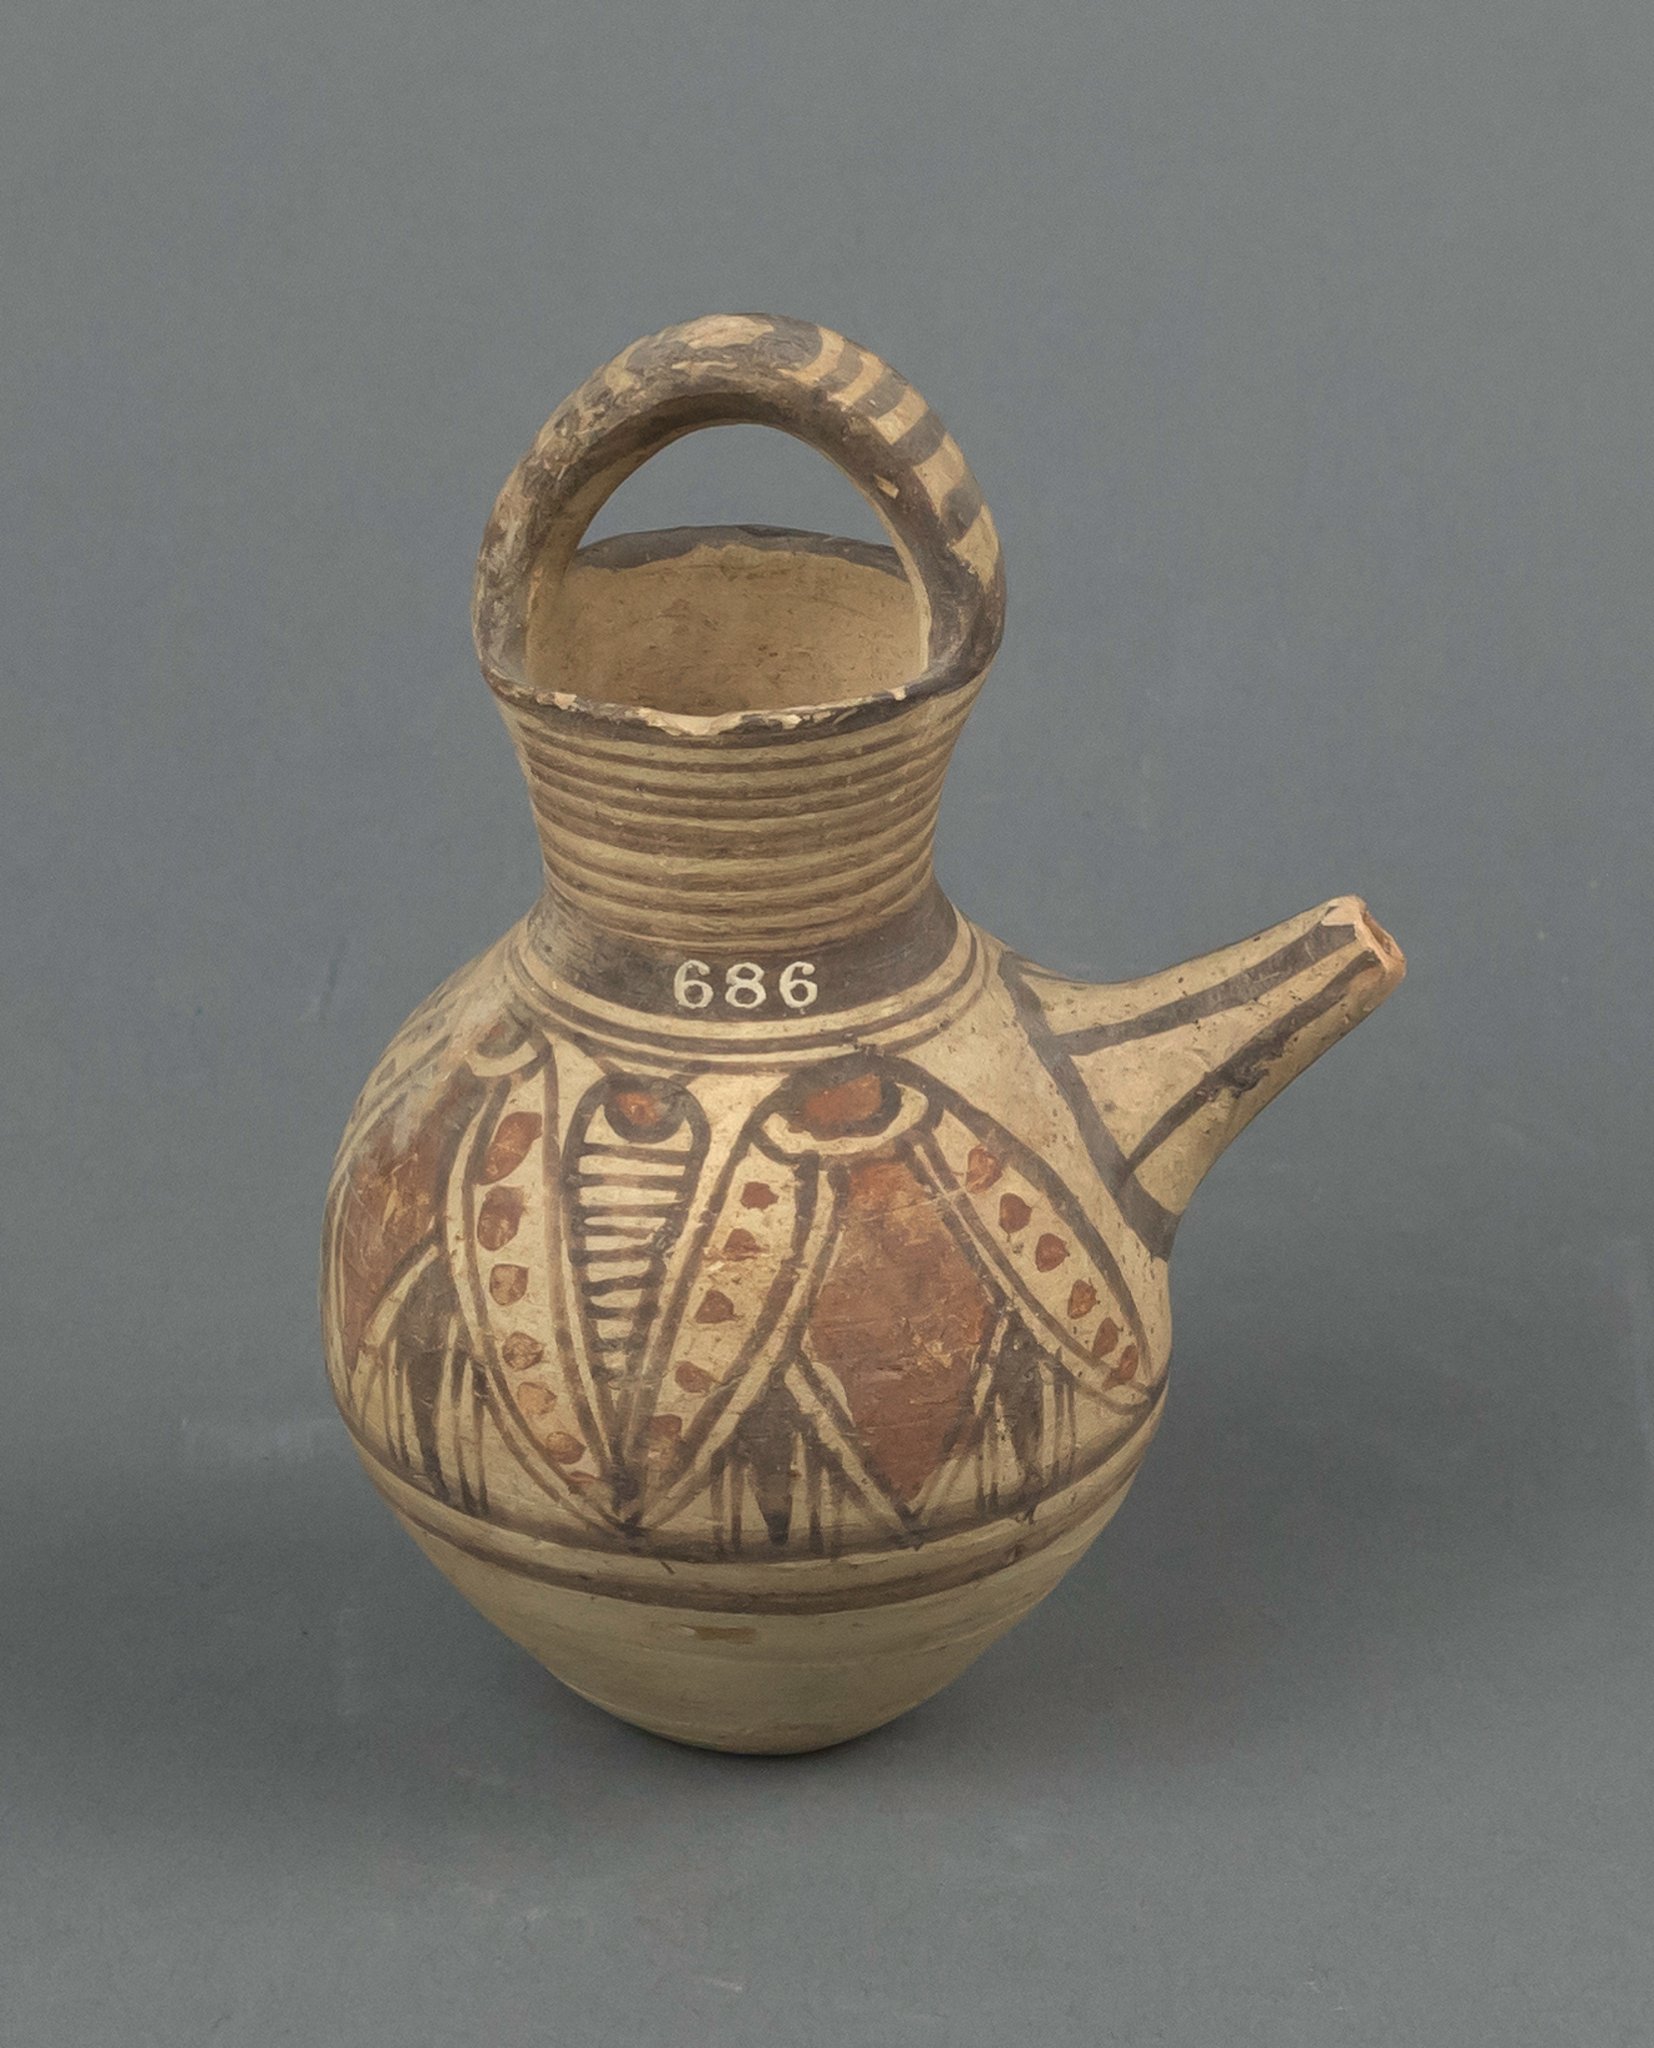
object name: juglet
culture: cypriot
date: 750-600 BCE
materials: terracotta